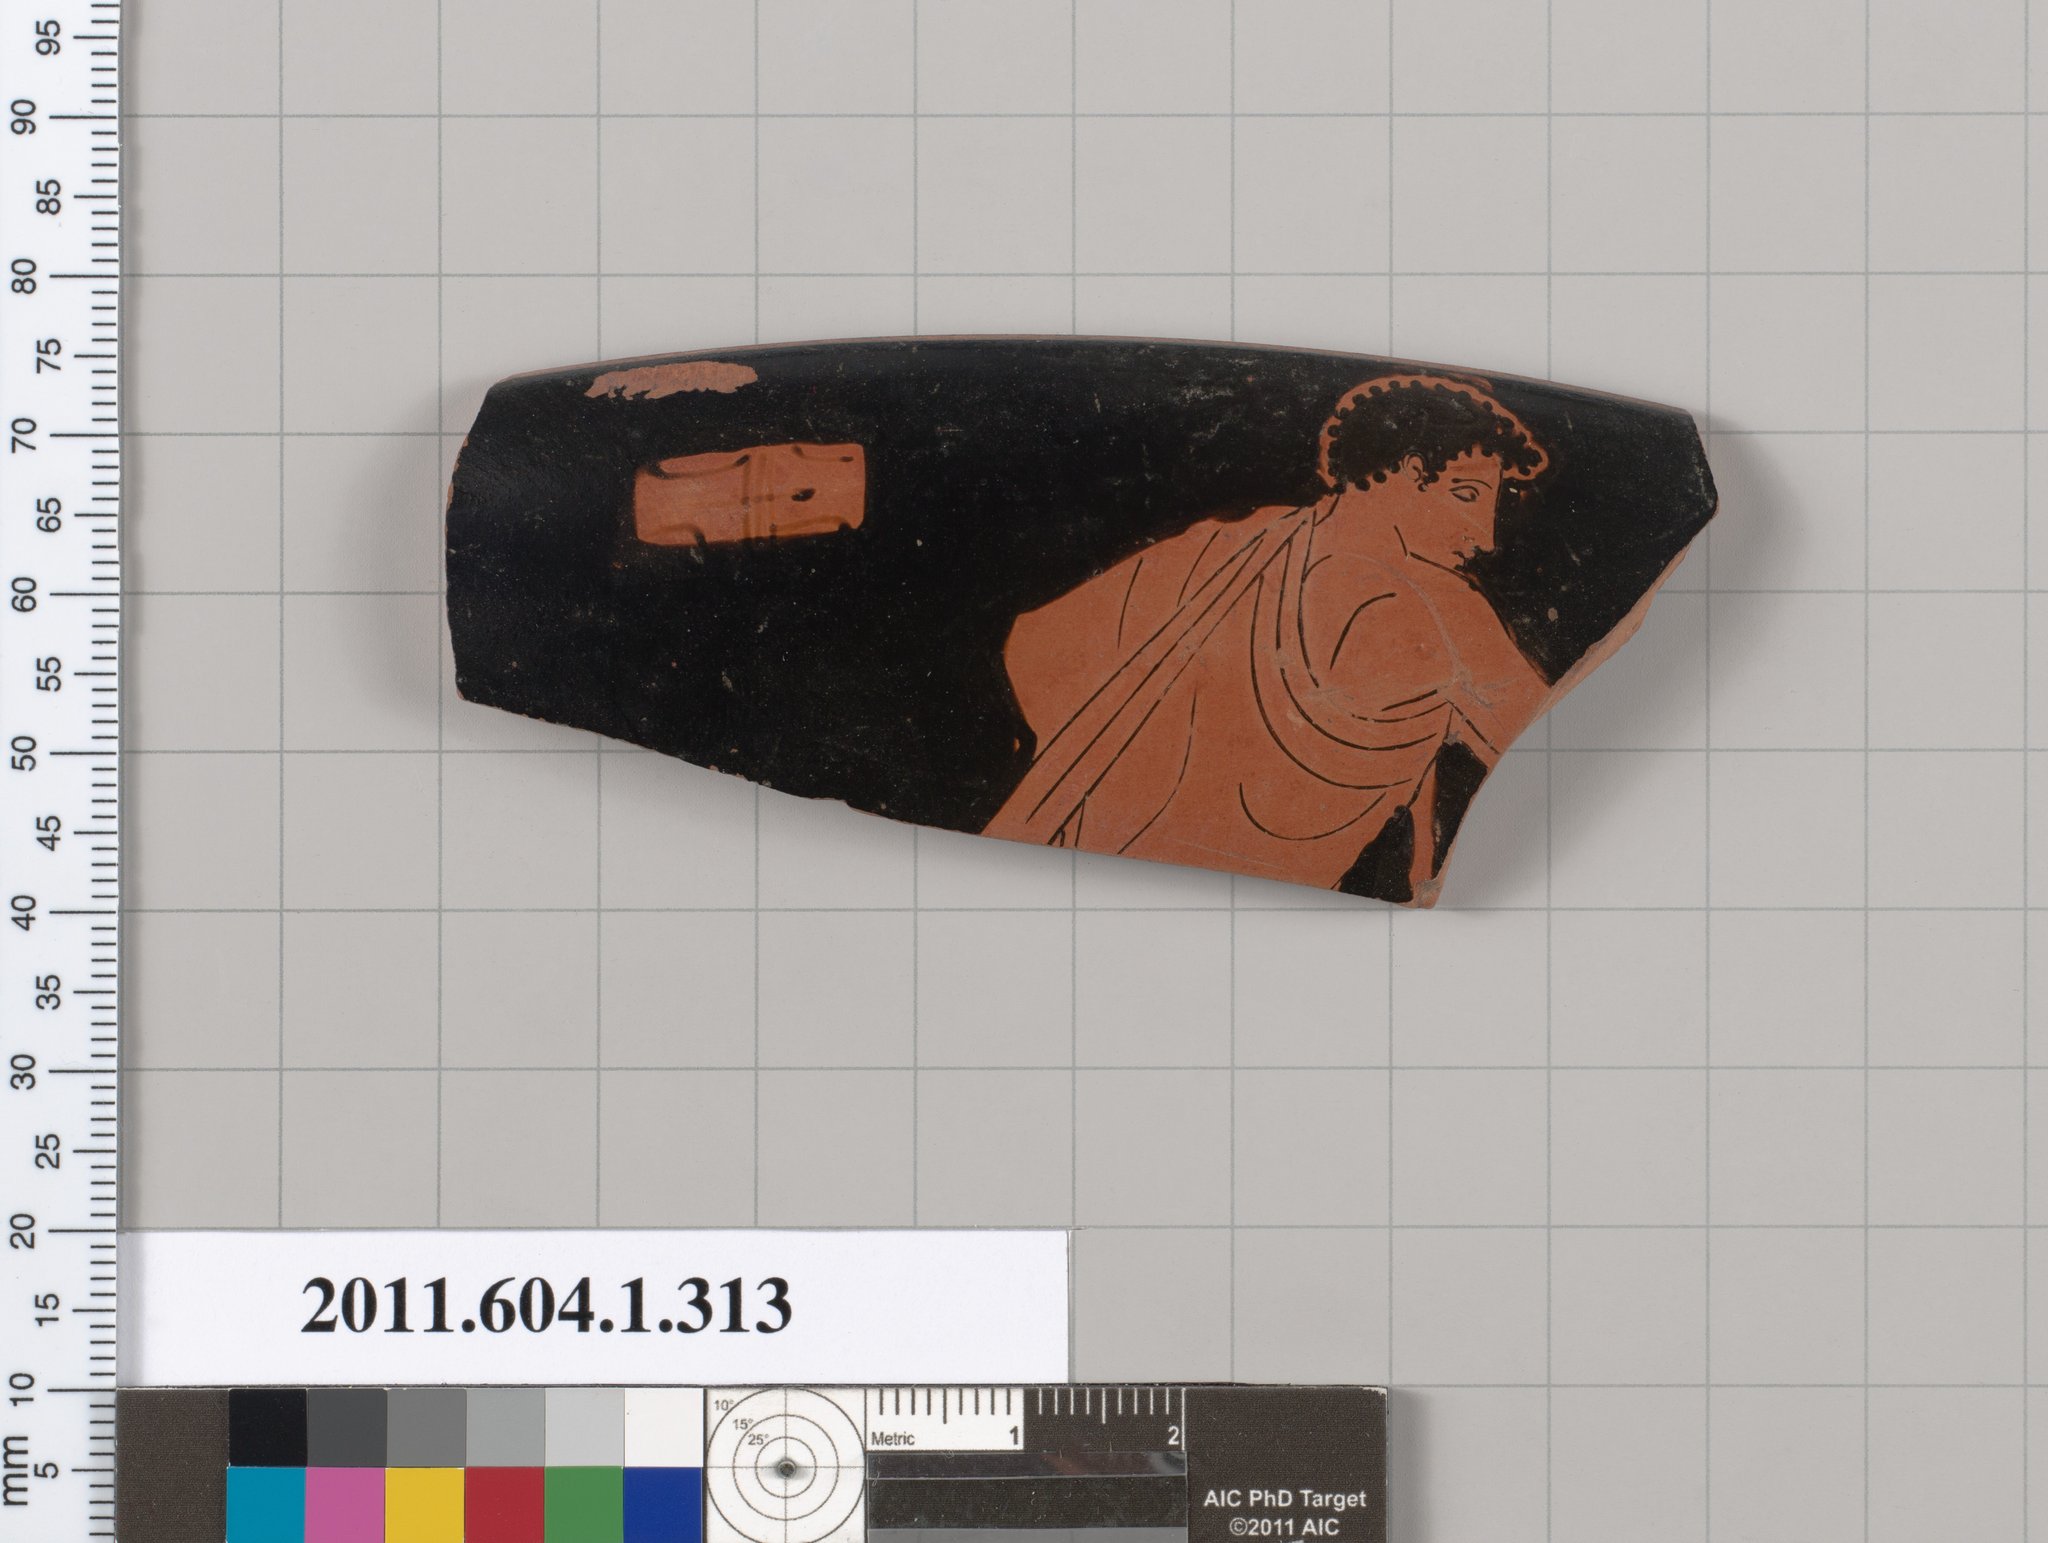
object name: kylix fragment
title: Terracotta rim fragment of a kylix (drinking cup)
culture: greek, attic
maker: pistoxenos painter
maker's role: artist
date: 475-451 BCE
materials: terracotta